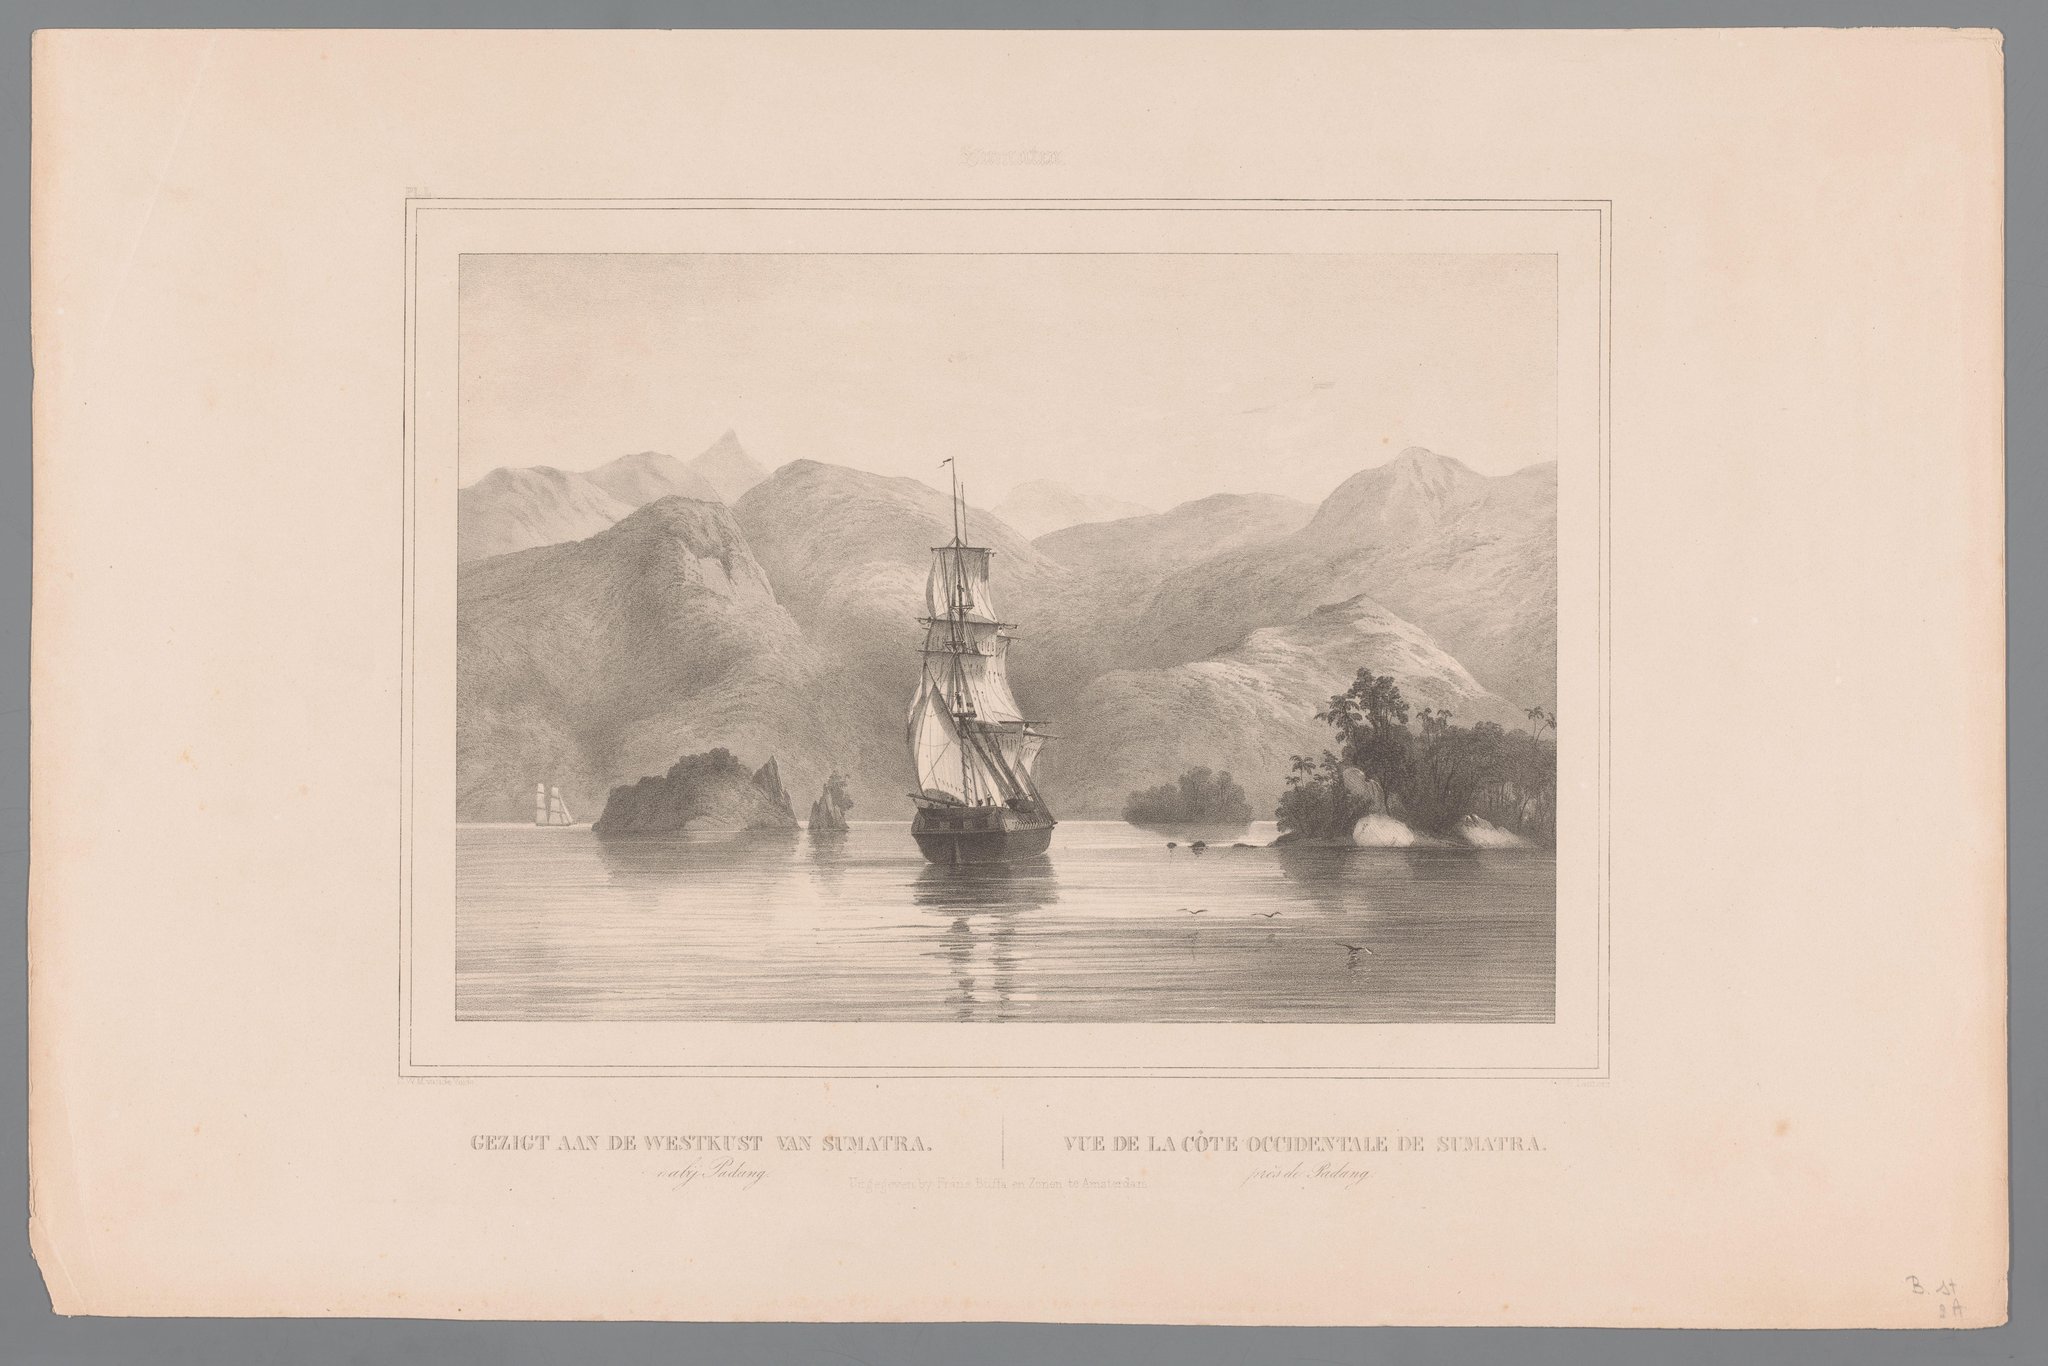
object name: print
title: Sumatra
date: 1847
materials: paper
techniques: lithograph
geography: amsterdam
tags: sailing-ship, sailing-boat, coast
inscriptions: collector's mark: Lugt 2228